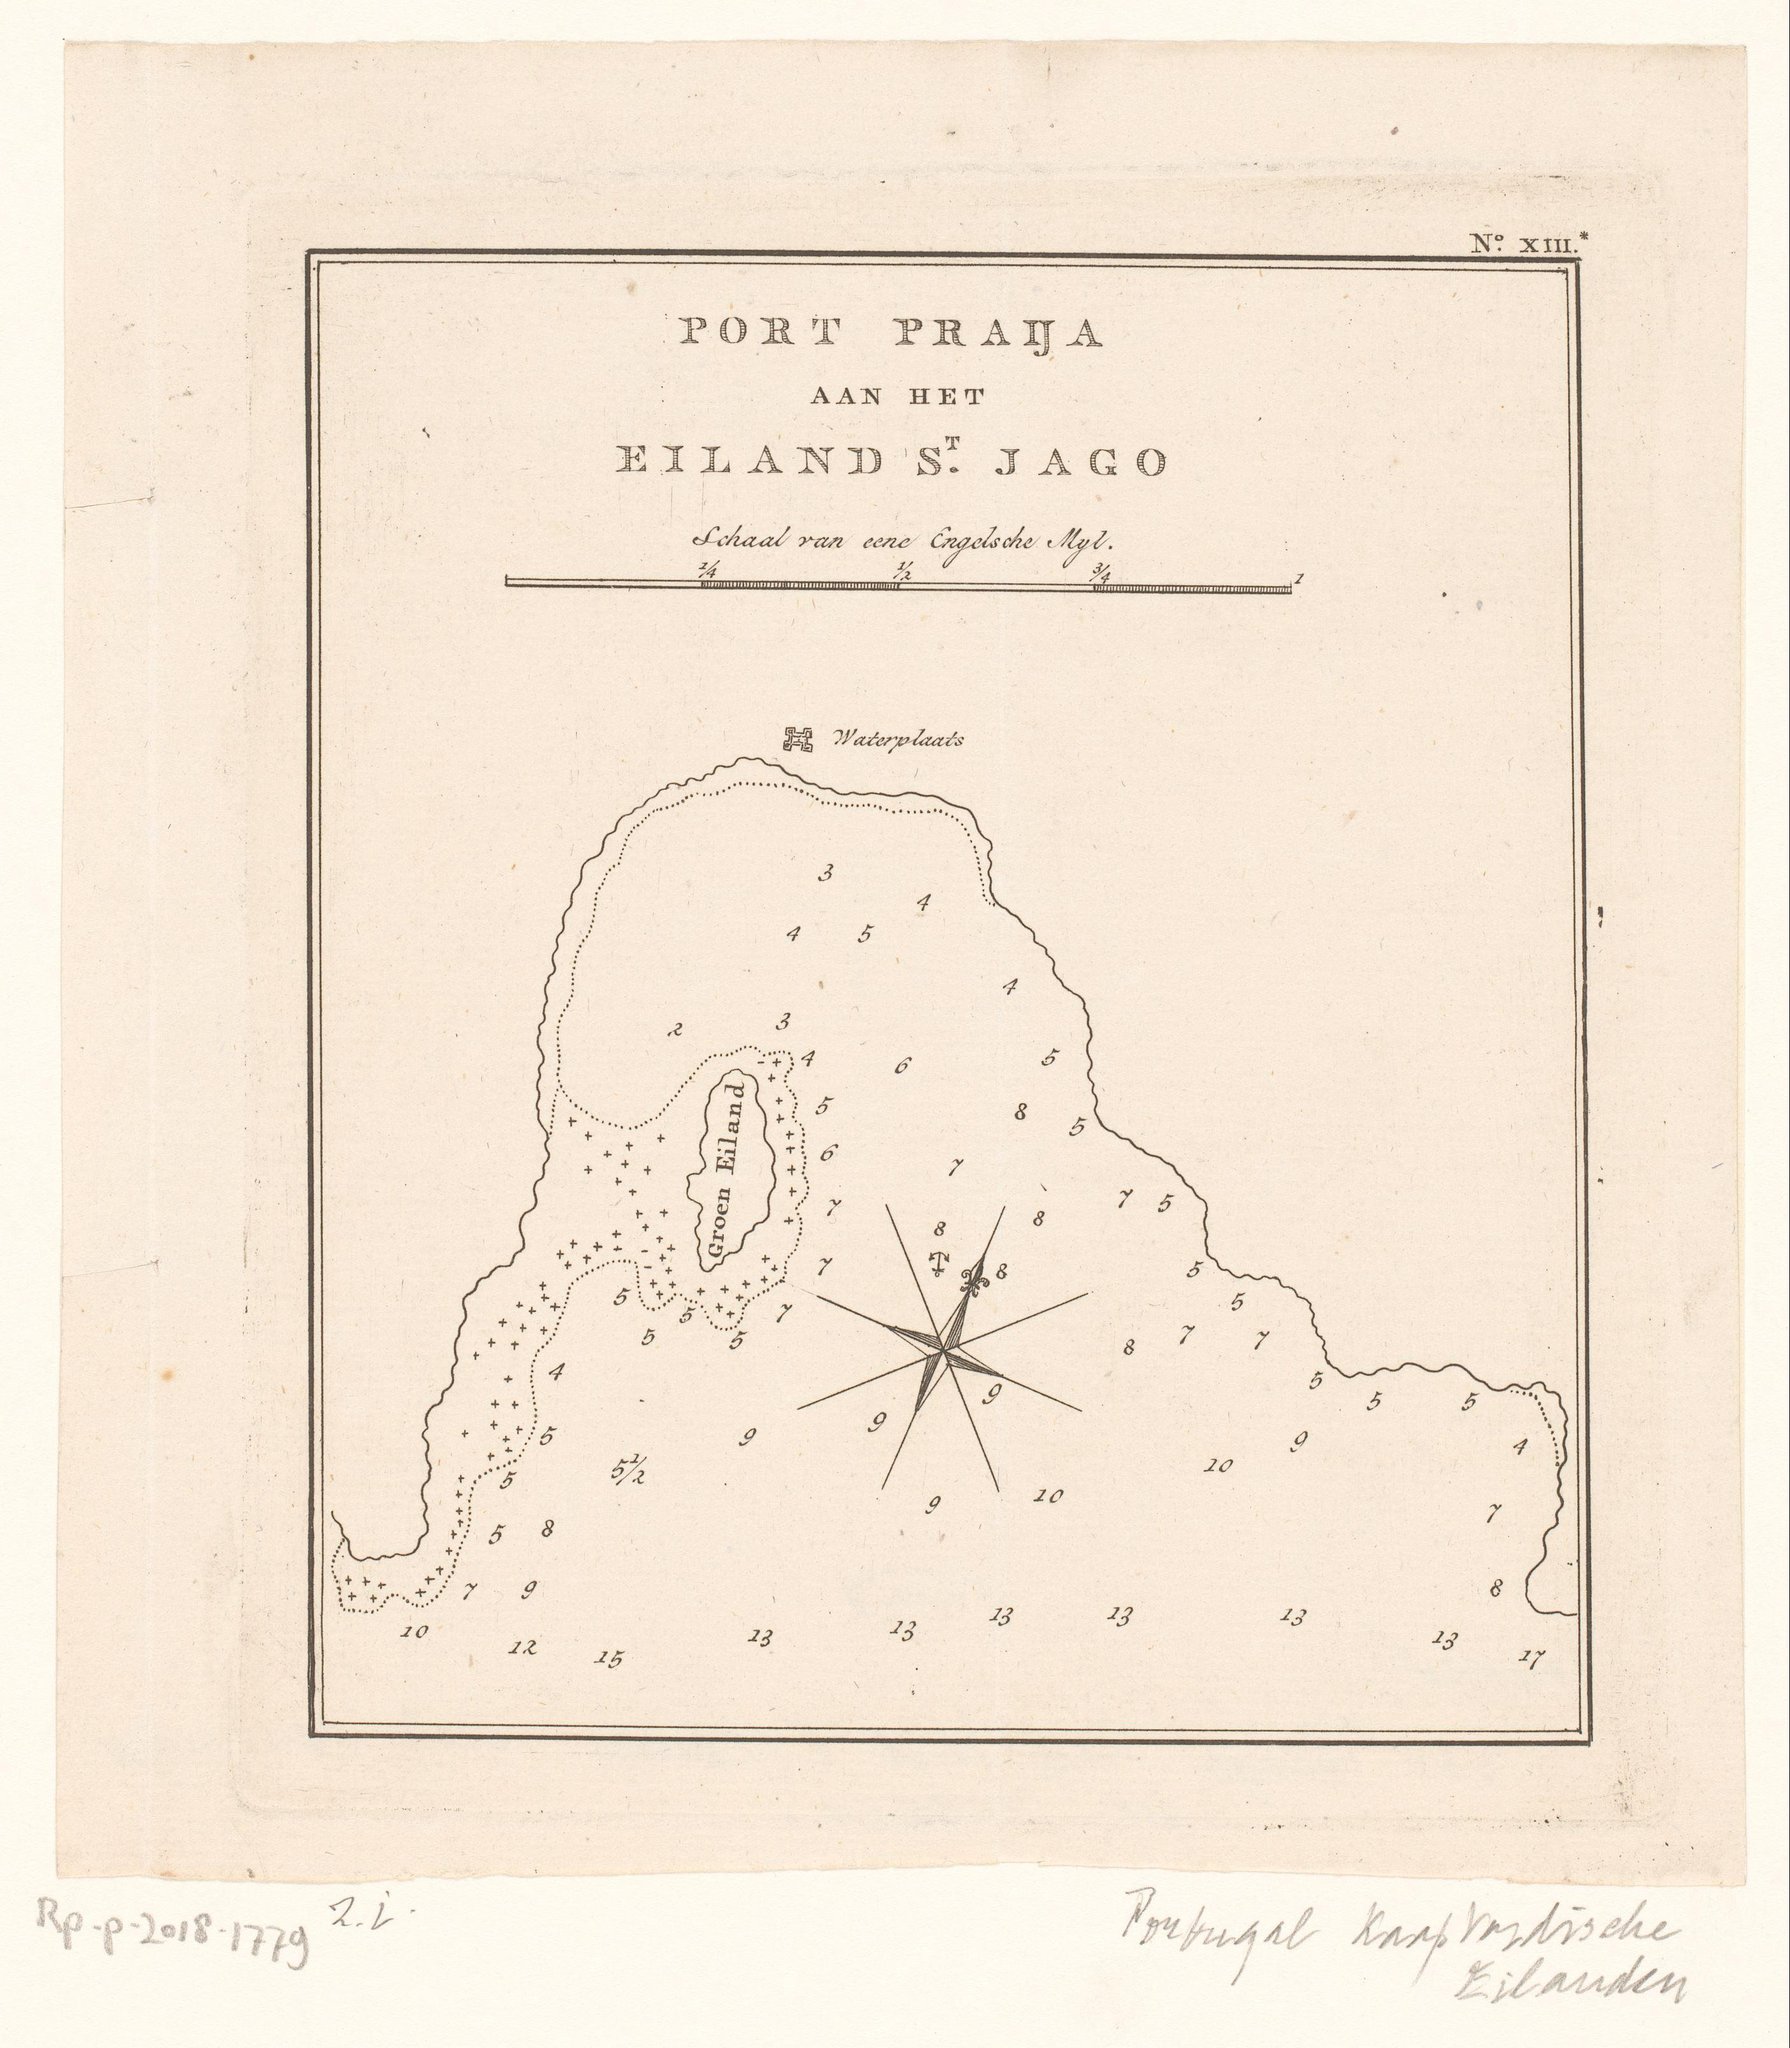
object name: print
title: Zeekaart van de haven van Praia, op het eiland Santiago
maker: Anonymous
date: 1795-1809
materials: paper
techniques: engraving, etching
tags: harbour, marine charts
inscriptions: collector's mark: Lugt 2228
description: Prent ook gebruikt in: Cook, James. Reize rondom de waereld. 13 dln. Amsterdam, Leiden, Den Haag: Isaak van Cleef, Jan en Abraham Honkoop en Johannes Allart. 1795-1809.